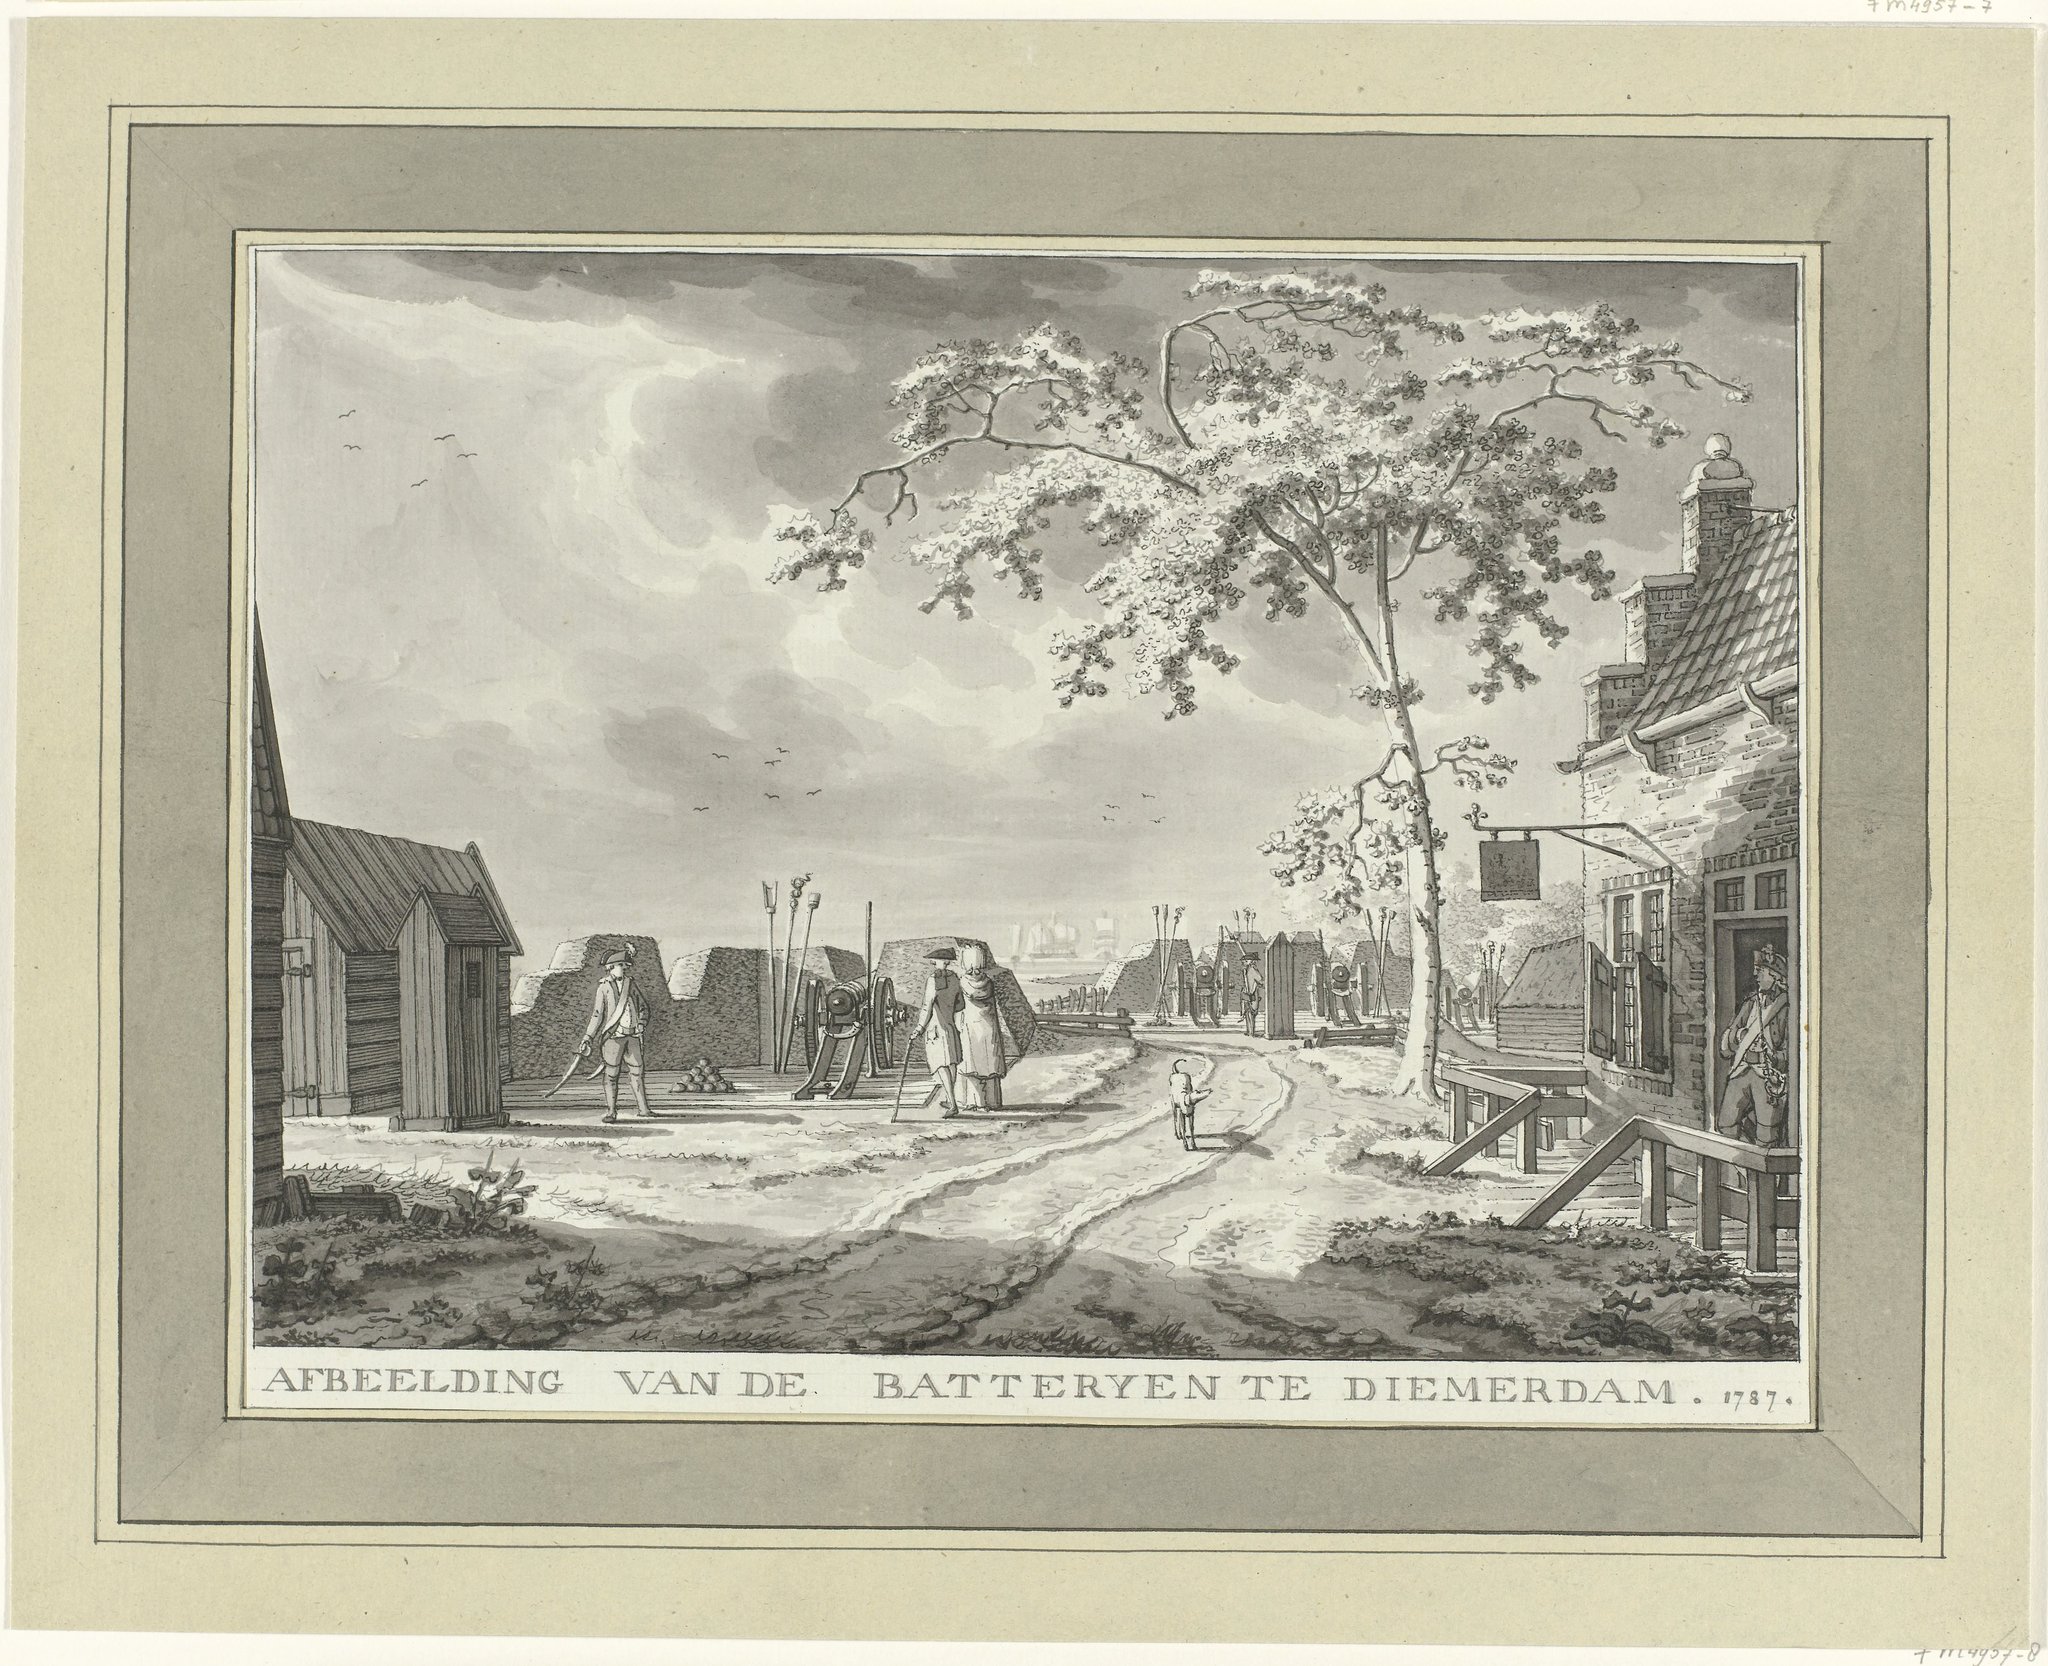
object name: drawing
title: Afbeelding van de Batteryen te Diemerdam. 1787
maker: Anonymous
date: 1787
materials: paper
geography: northern netherlands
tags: defence of fortification or city, defensive measures (military)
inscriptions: collector's mark: Lugt 2228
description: Battterij aan de Diemerdam. Onderdeel van een groep van tien tekeningen van de verdedigingen aangelegd door de patriotten rondom Amsterdam ten tijde van de inval van de Pruisische troepen in september 1787.